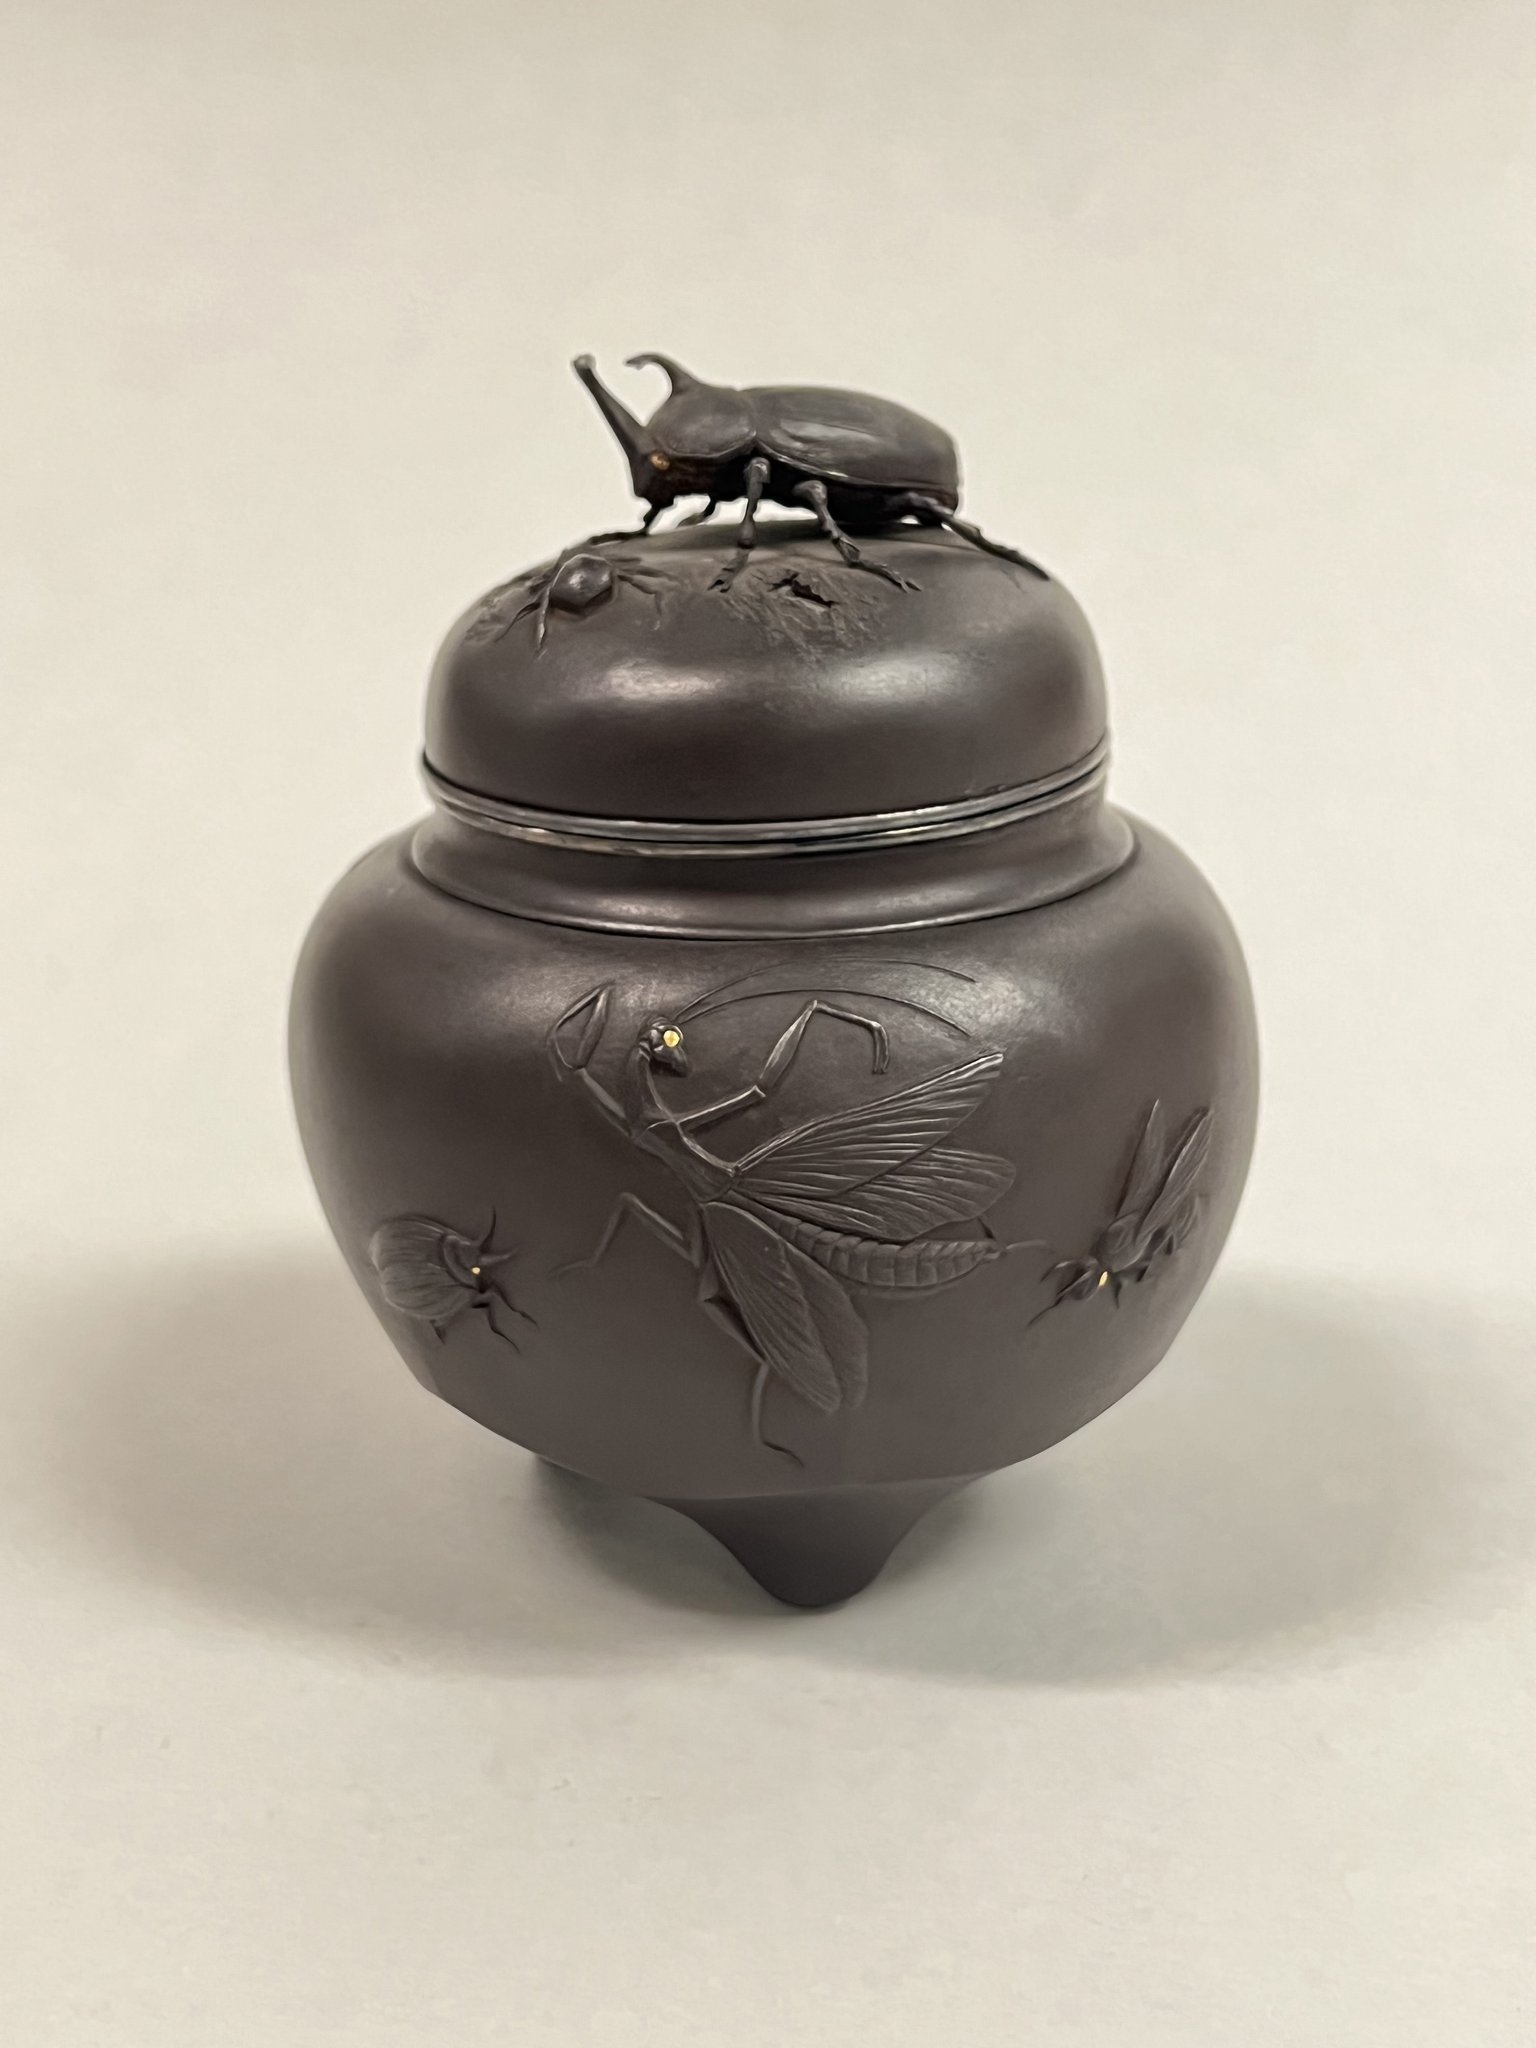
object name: vase with cover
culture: japanese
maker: seiriucho hidetoshi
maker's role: artist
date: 1801-1900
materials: iron